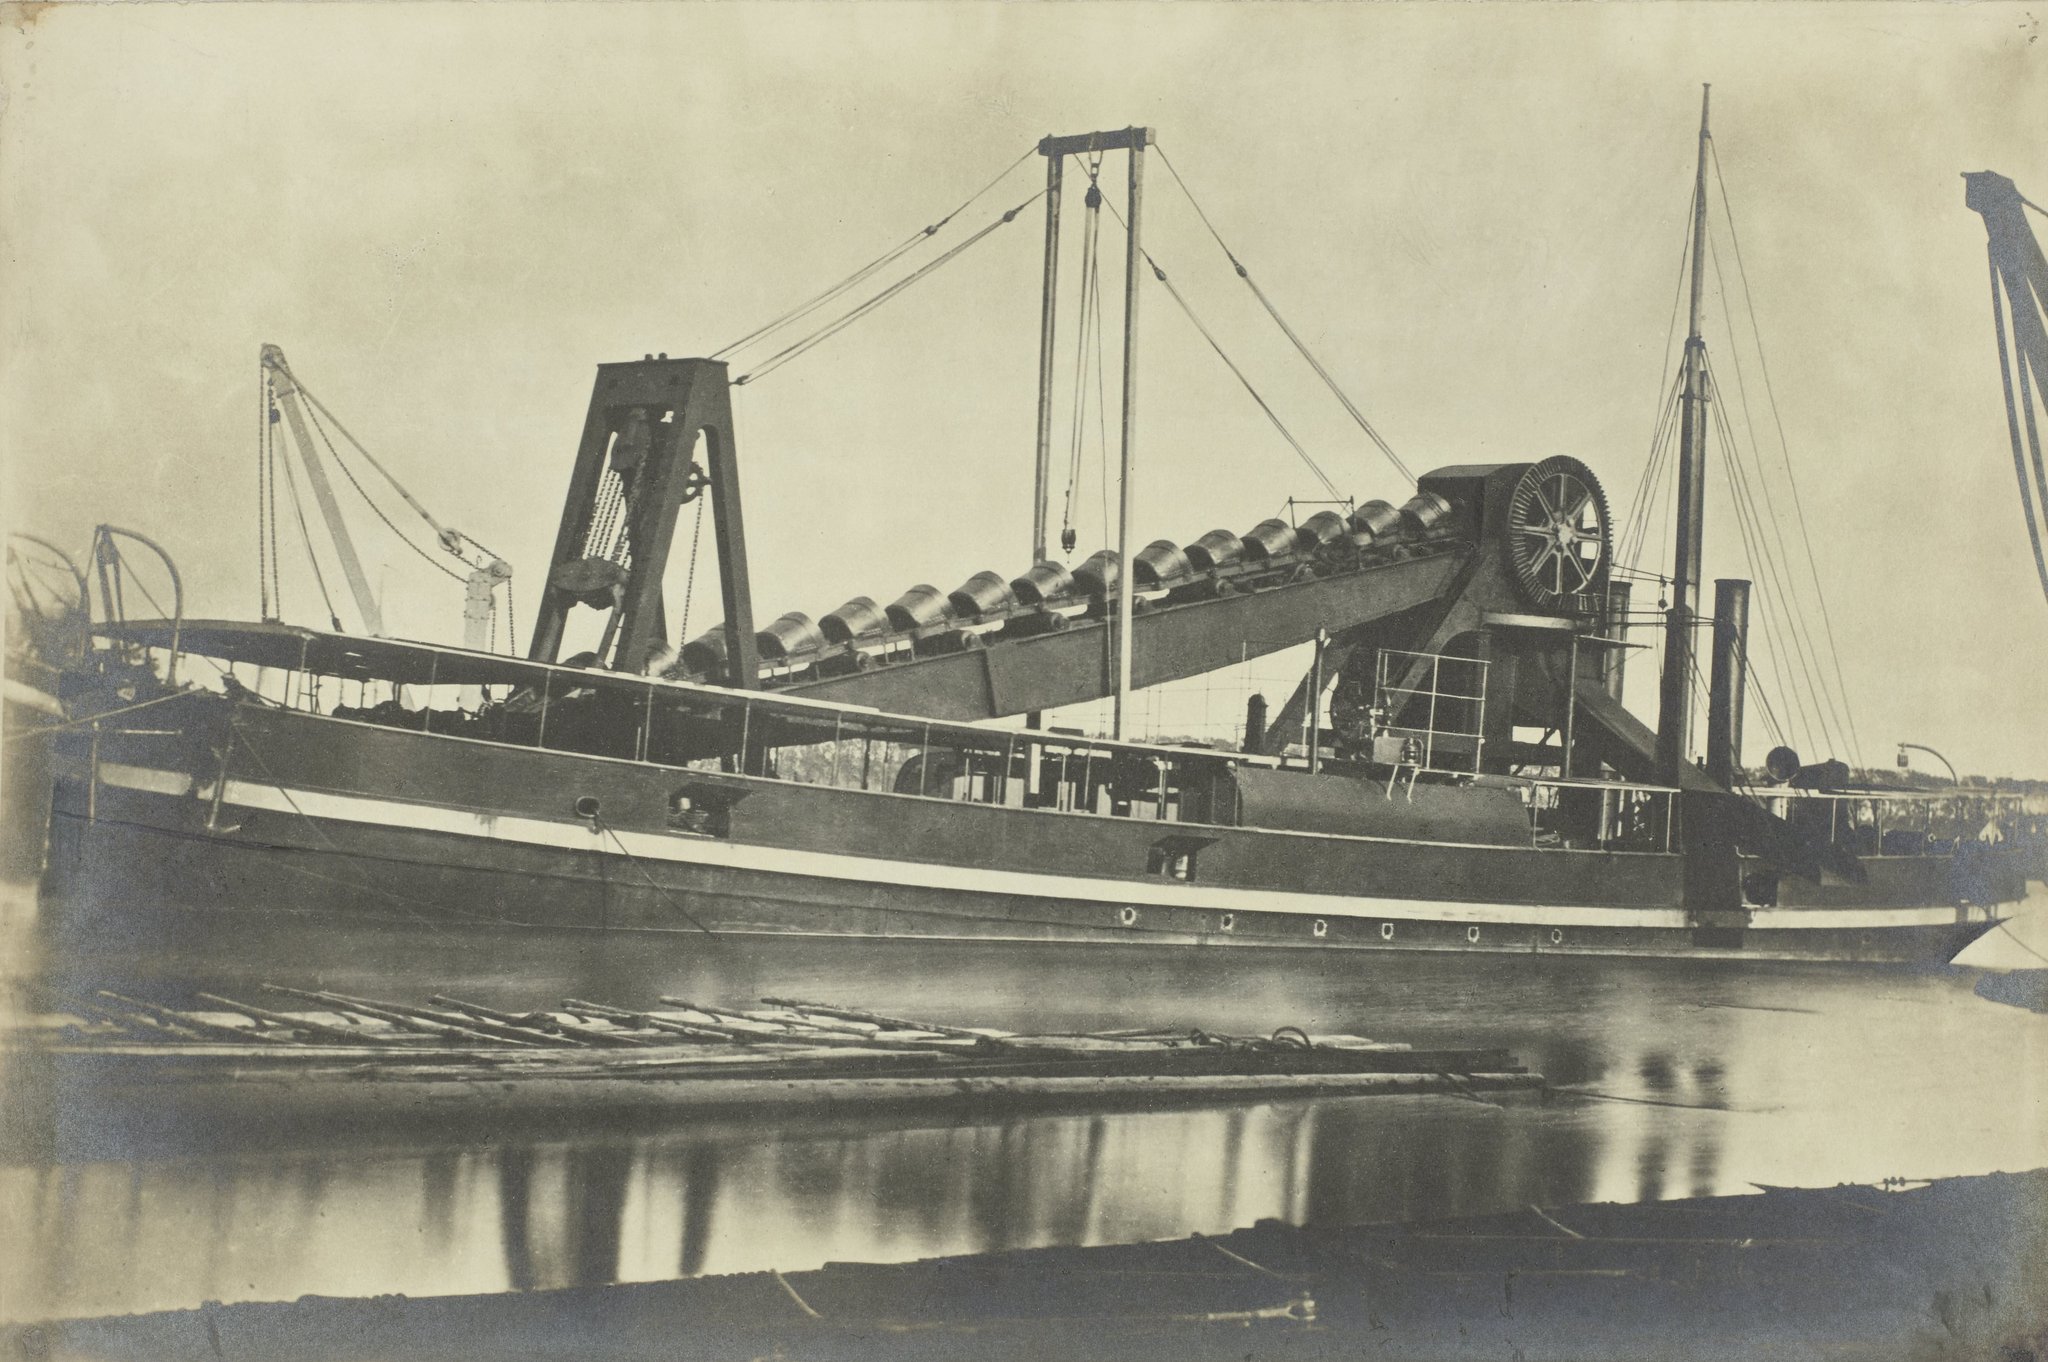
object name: photograph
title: Baggerschip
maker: dorp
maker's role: fotograaf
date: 1894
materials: cardboard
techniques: photography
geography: rotterdam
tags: netherlands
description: Baggerschip 'Aberak No 3' van de Batavische Havenwerken 1894. Opschrift. Keerzijde: (aantekening in potlood).